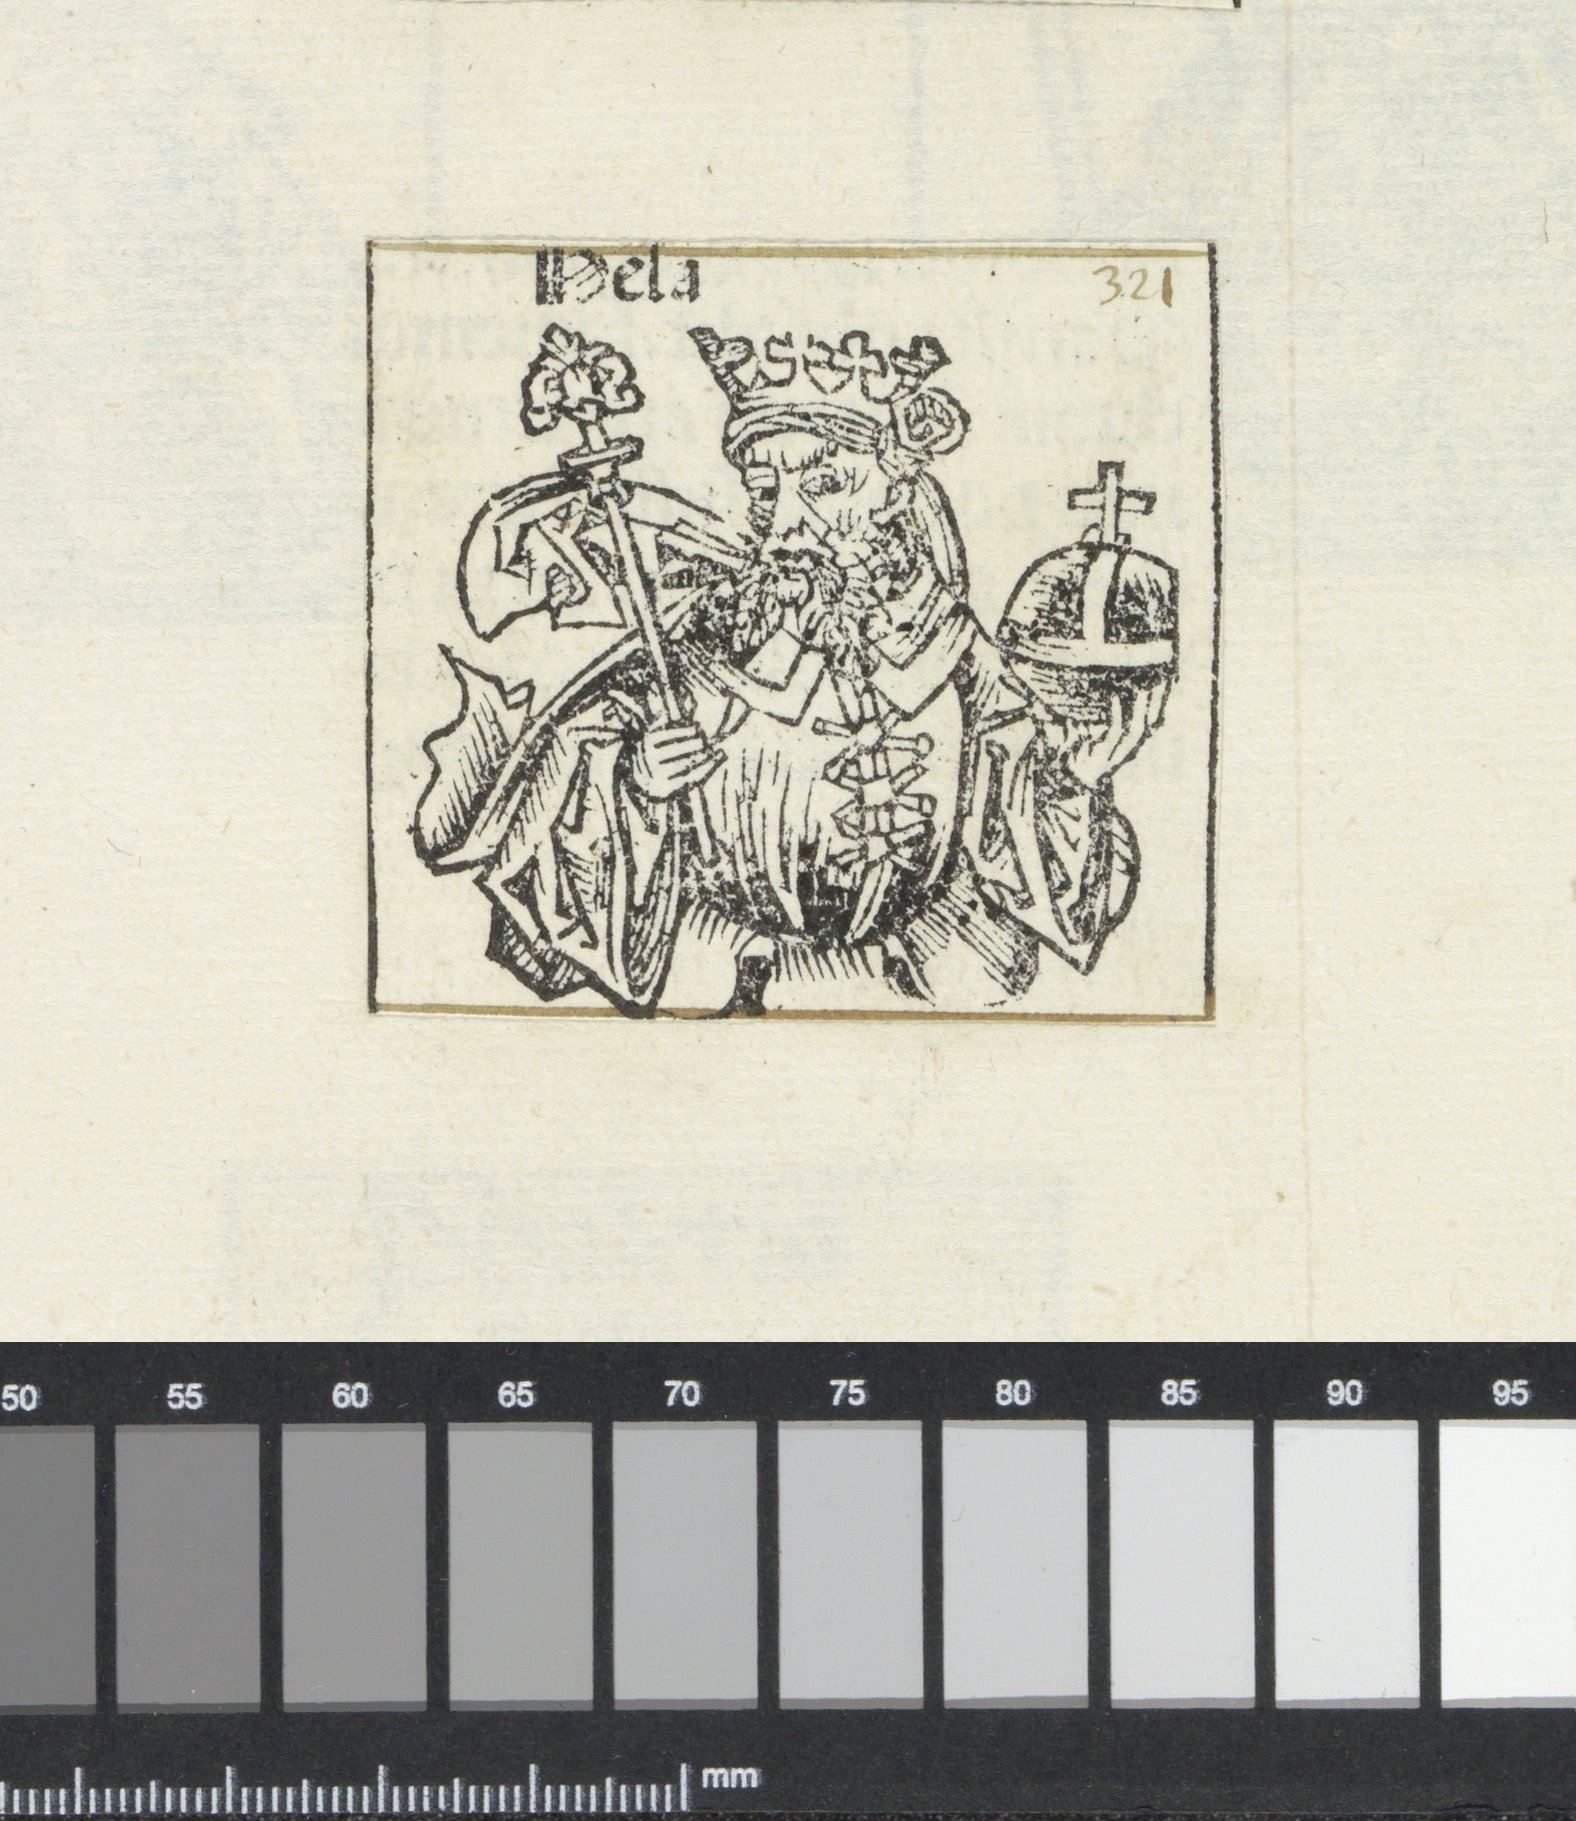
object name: album leaf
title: Liber Chronicarum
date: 1493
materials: paper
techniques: letterpress printing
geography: nuremberg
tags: king, persons from the old testament (not in biblical context, nor occurring in legendary/historical extensions included in division 71)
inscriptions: inscription: ‘321’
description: Een bloemkelk met een koning. Hij heeft een rijksappel en een scepter in zijn handen. De voorstelling is onderdeel van de opeenvolging van de koningen van Israël in de Liber Chronicarum. De tekst identificeert de man als Ela. De prent maakt deel uit van een album.